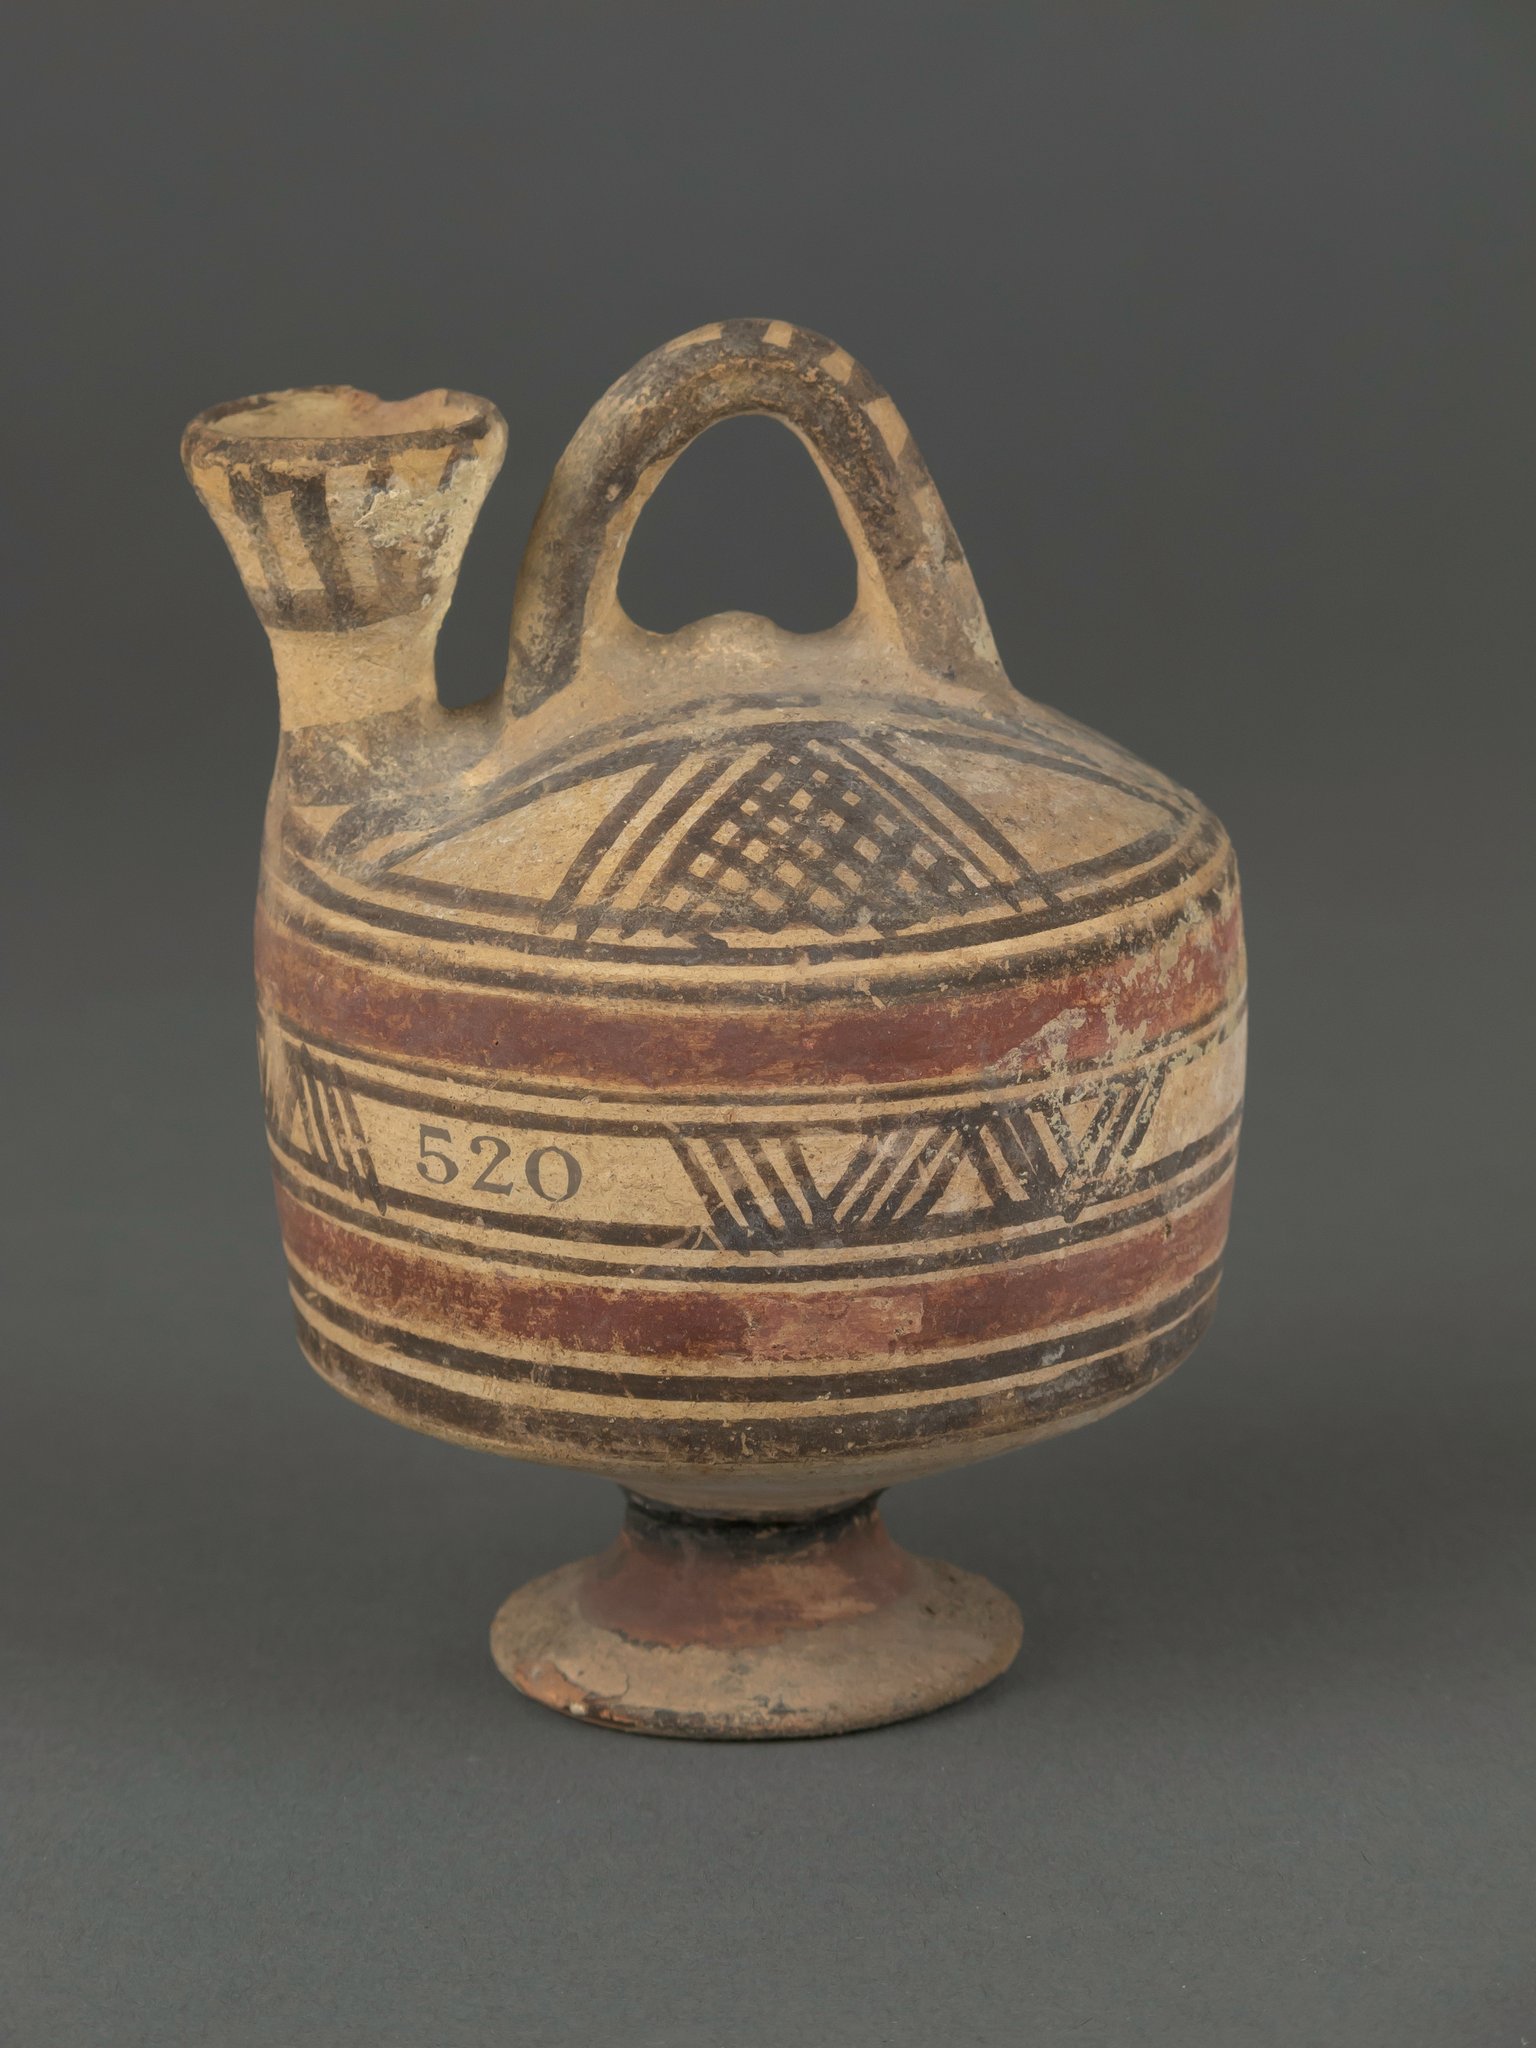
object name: false necked jar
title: False-necked jar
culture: cypriot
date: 1050-900 BCE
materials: terracotta